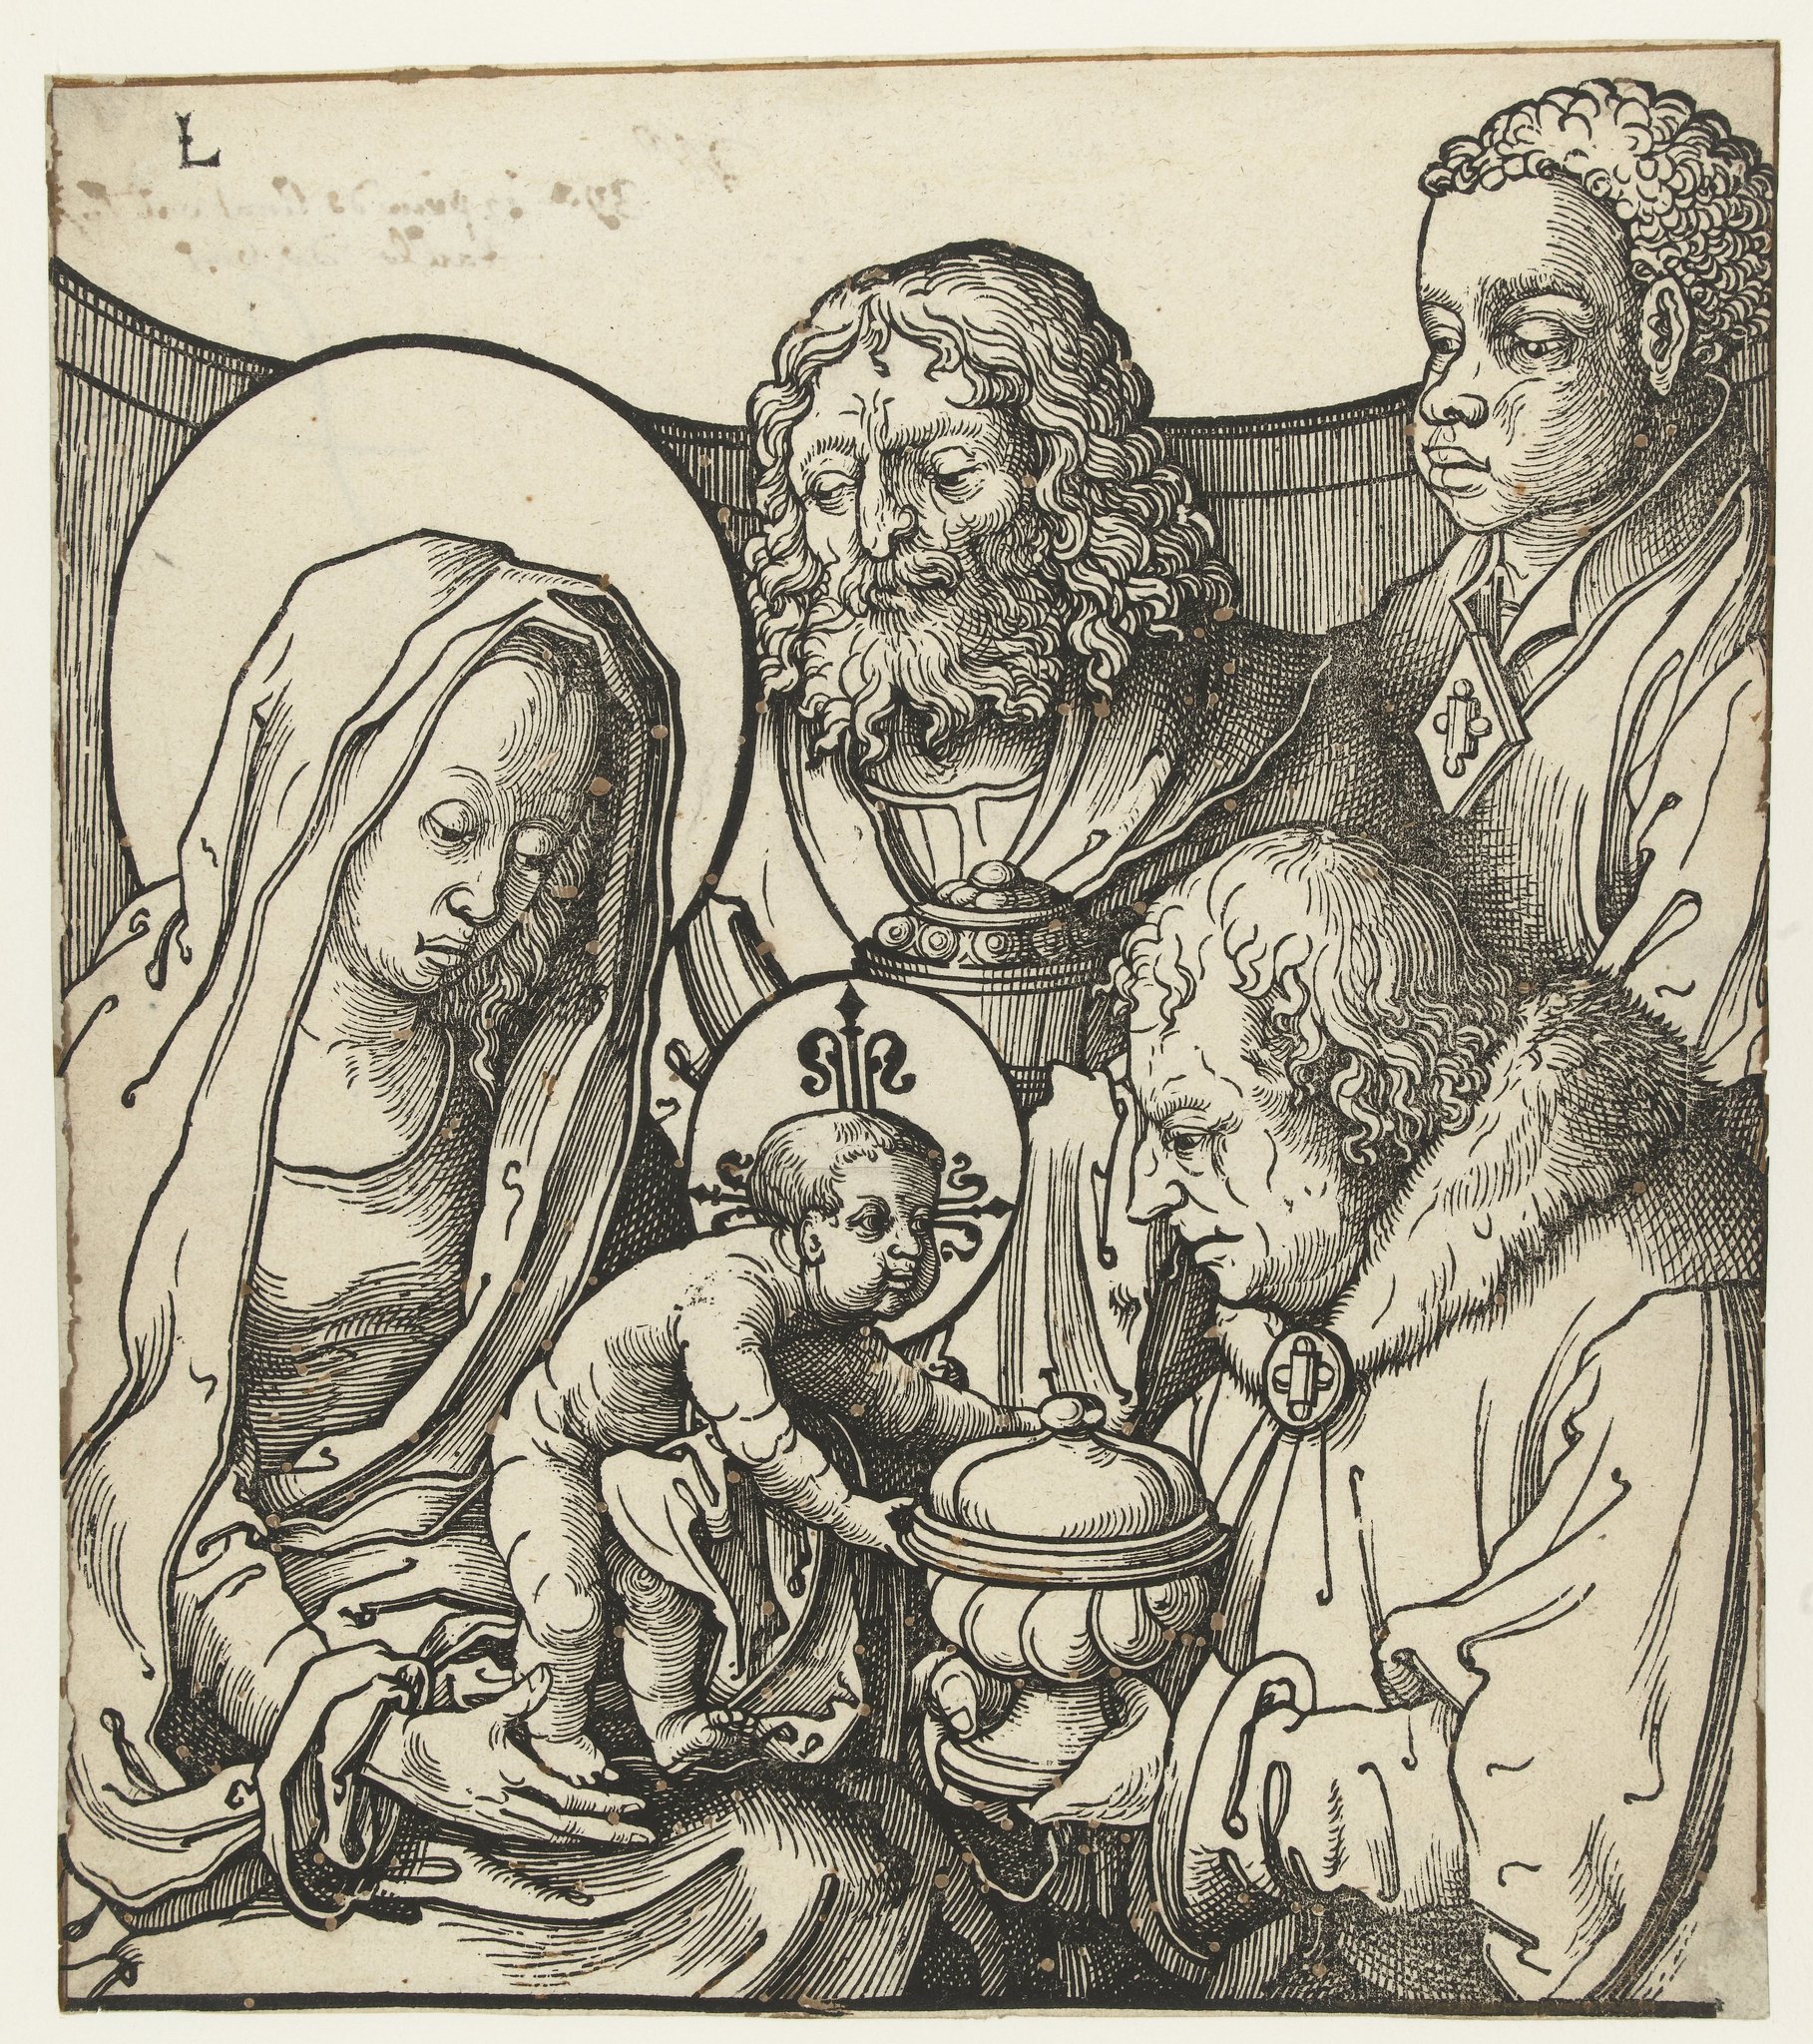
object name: print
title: De aanbidding der koningen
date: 1513-1583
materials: paper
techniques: retouching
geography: low countries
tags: adoration of the kings: the wise men present their gifts to the christ-child (gold, frankincense and myrrh)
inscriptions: collector's mark: Lugt 2228a, inscription: ‘Wo 390 13 pièces(?) de Lucas van Ley[en] taillo de bois’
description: De aanbidding van het Christuskind door de drie koningen. Gedrukt van houtblok met houtworm, prent opgewerkt met penseel. Initiaal L toegevoegd met pen linksboven.